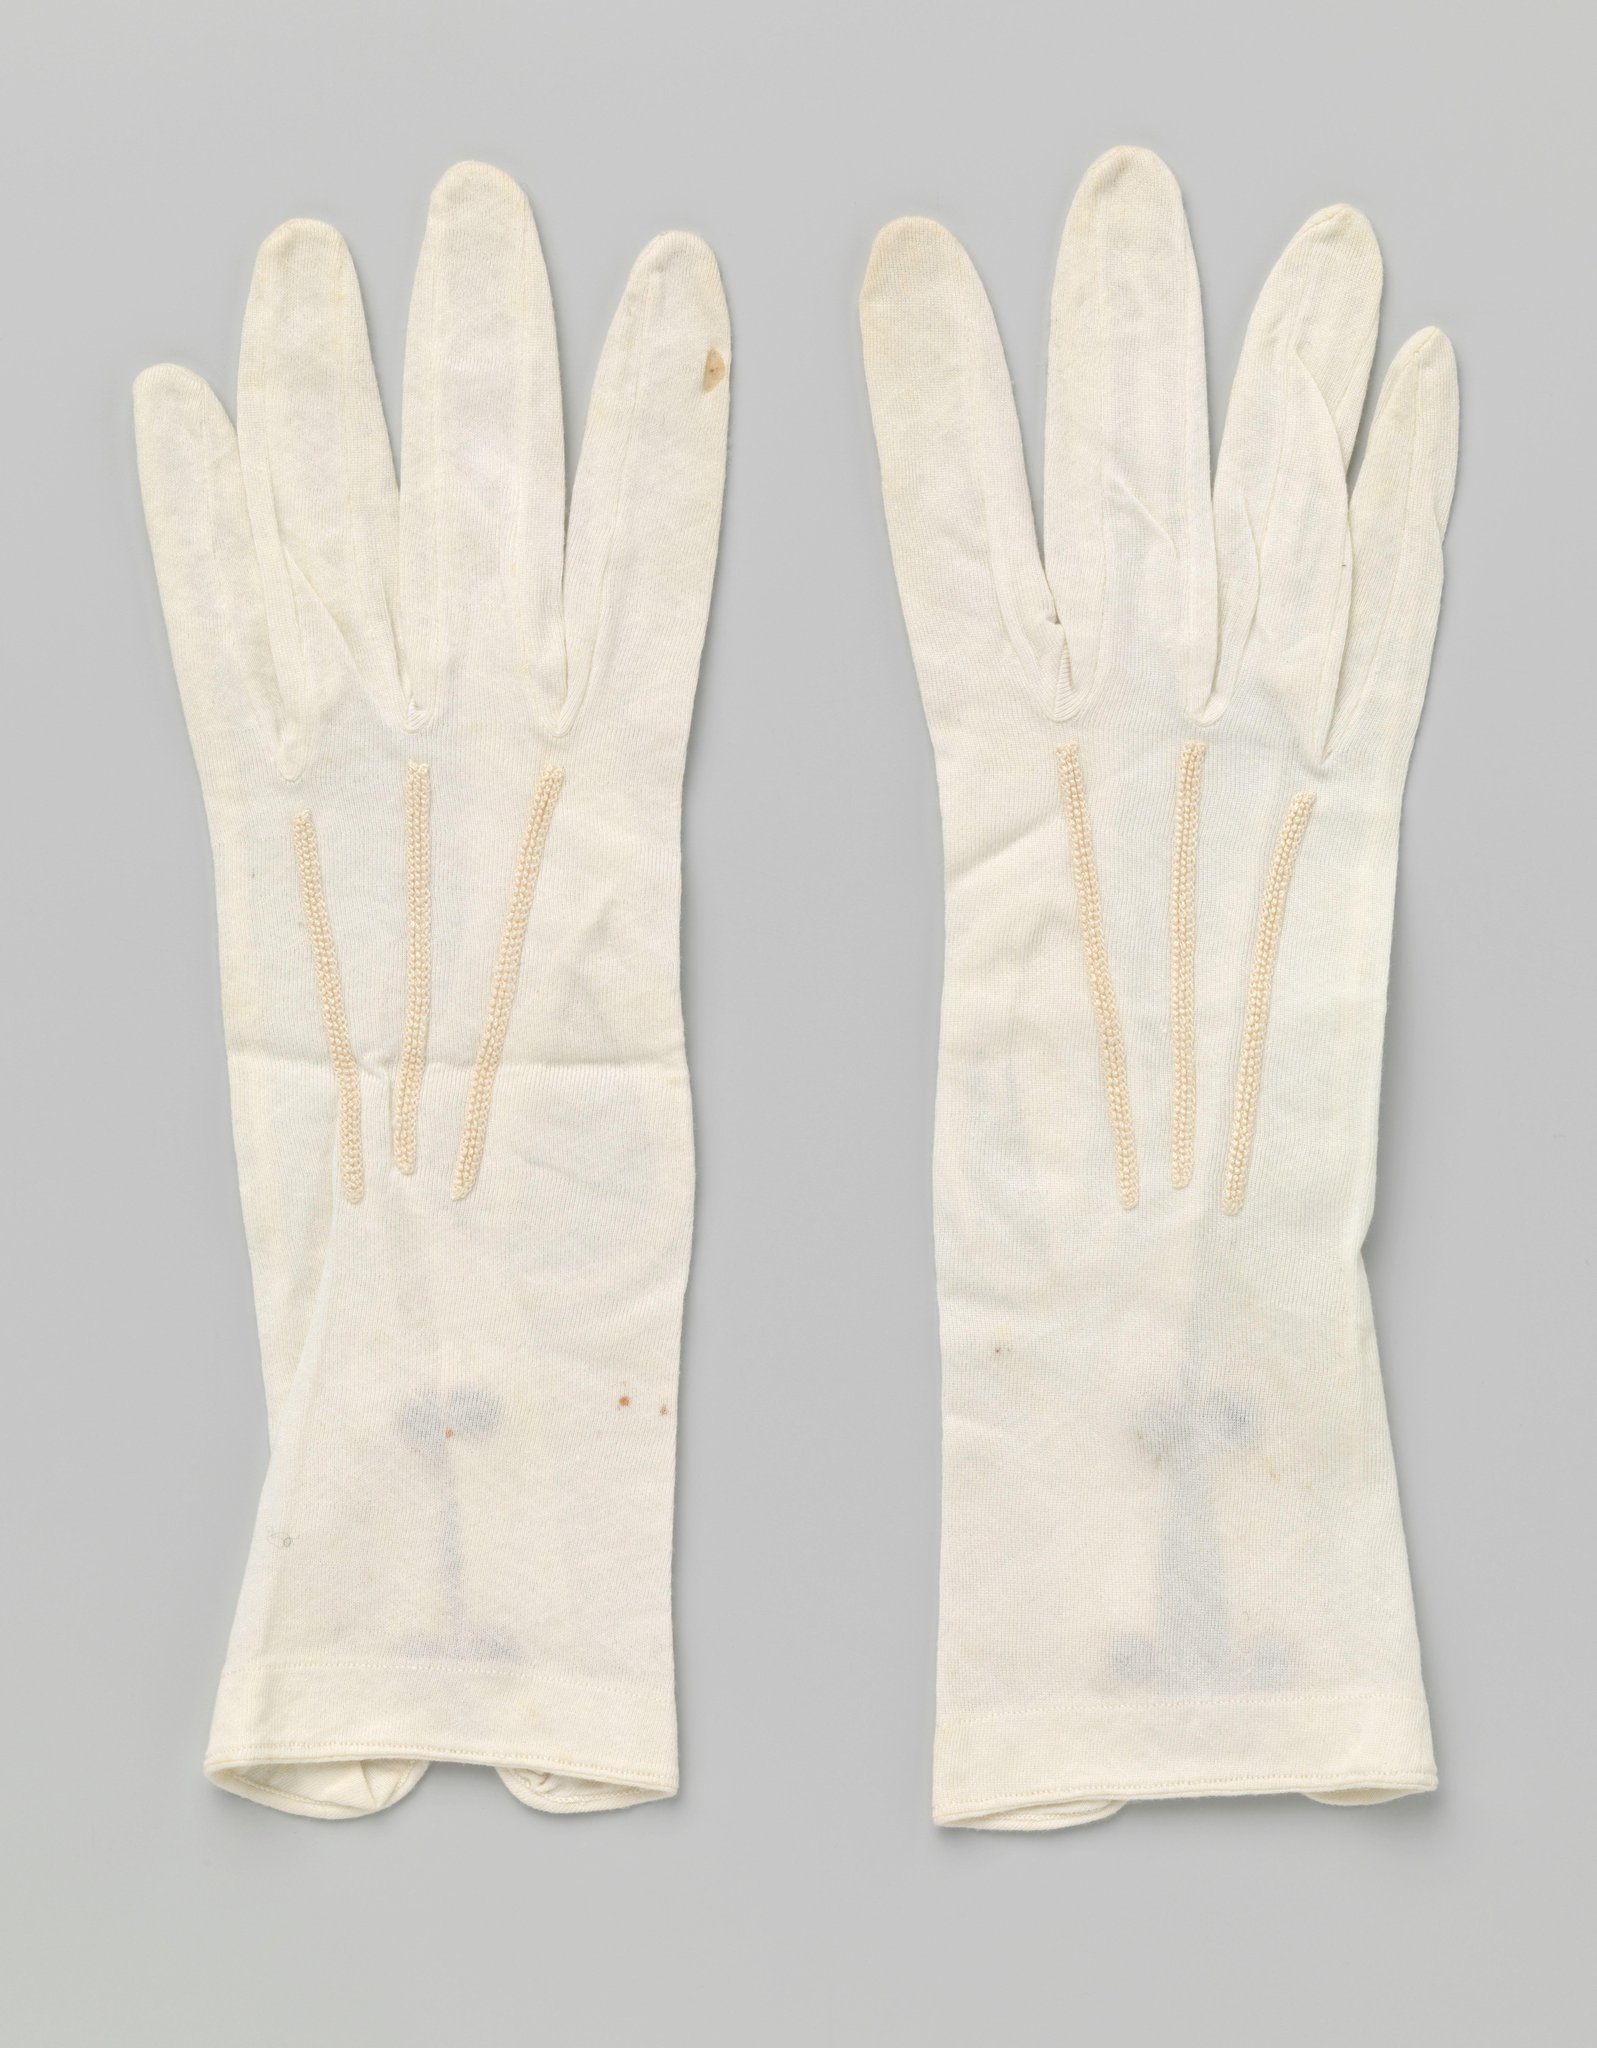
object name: glove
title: Handschoen van witte tricot met split en twee drukknopen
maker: Anonymous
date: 1900-1925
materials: cotton, plastic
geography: netherlands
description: Rechter handschoen, deel van een paar, van witte katoenen tricot met split en twee drukknopen.